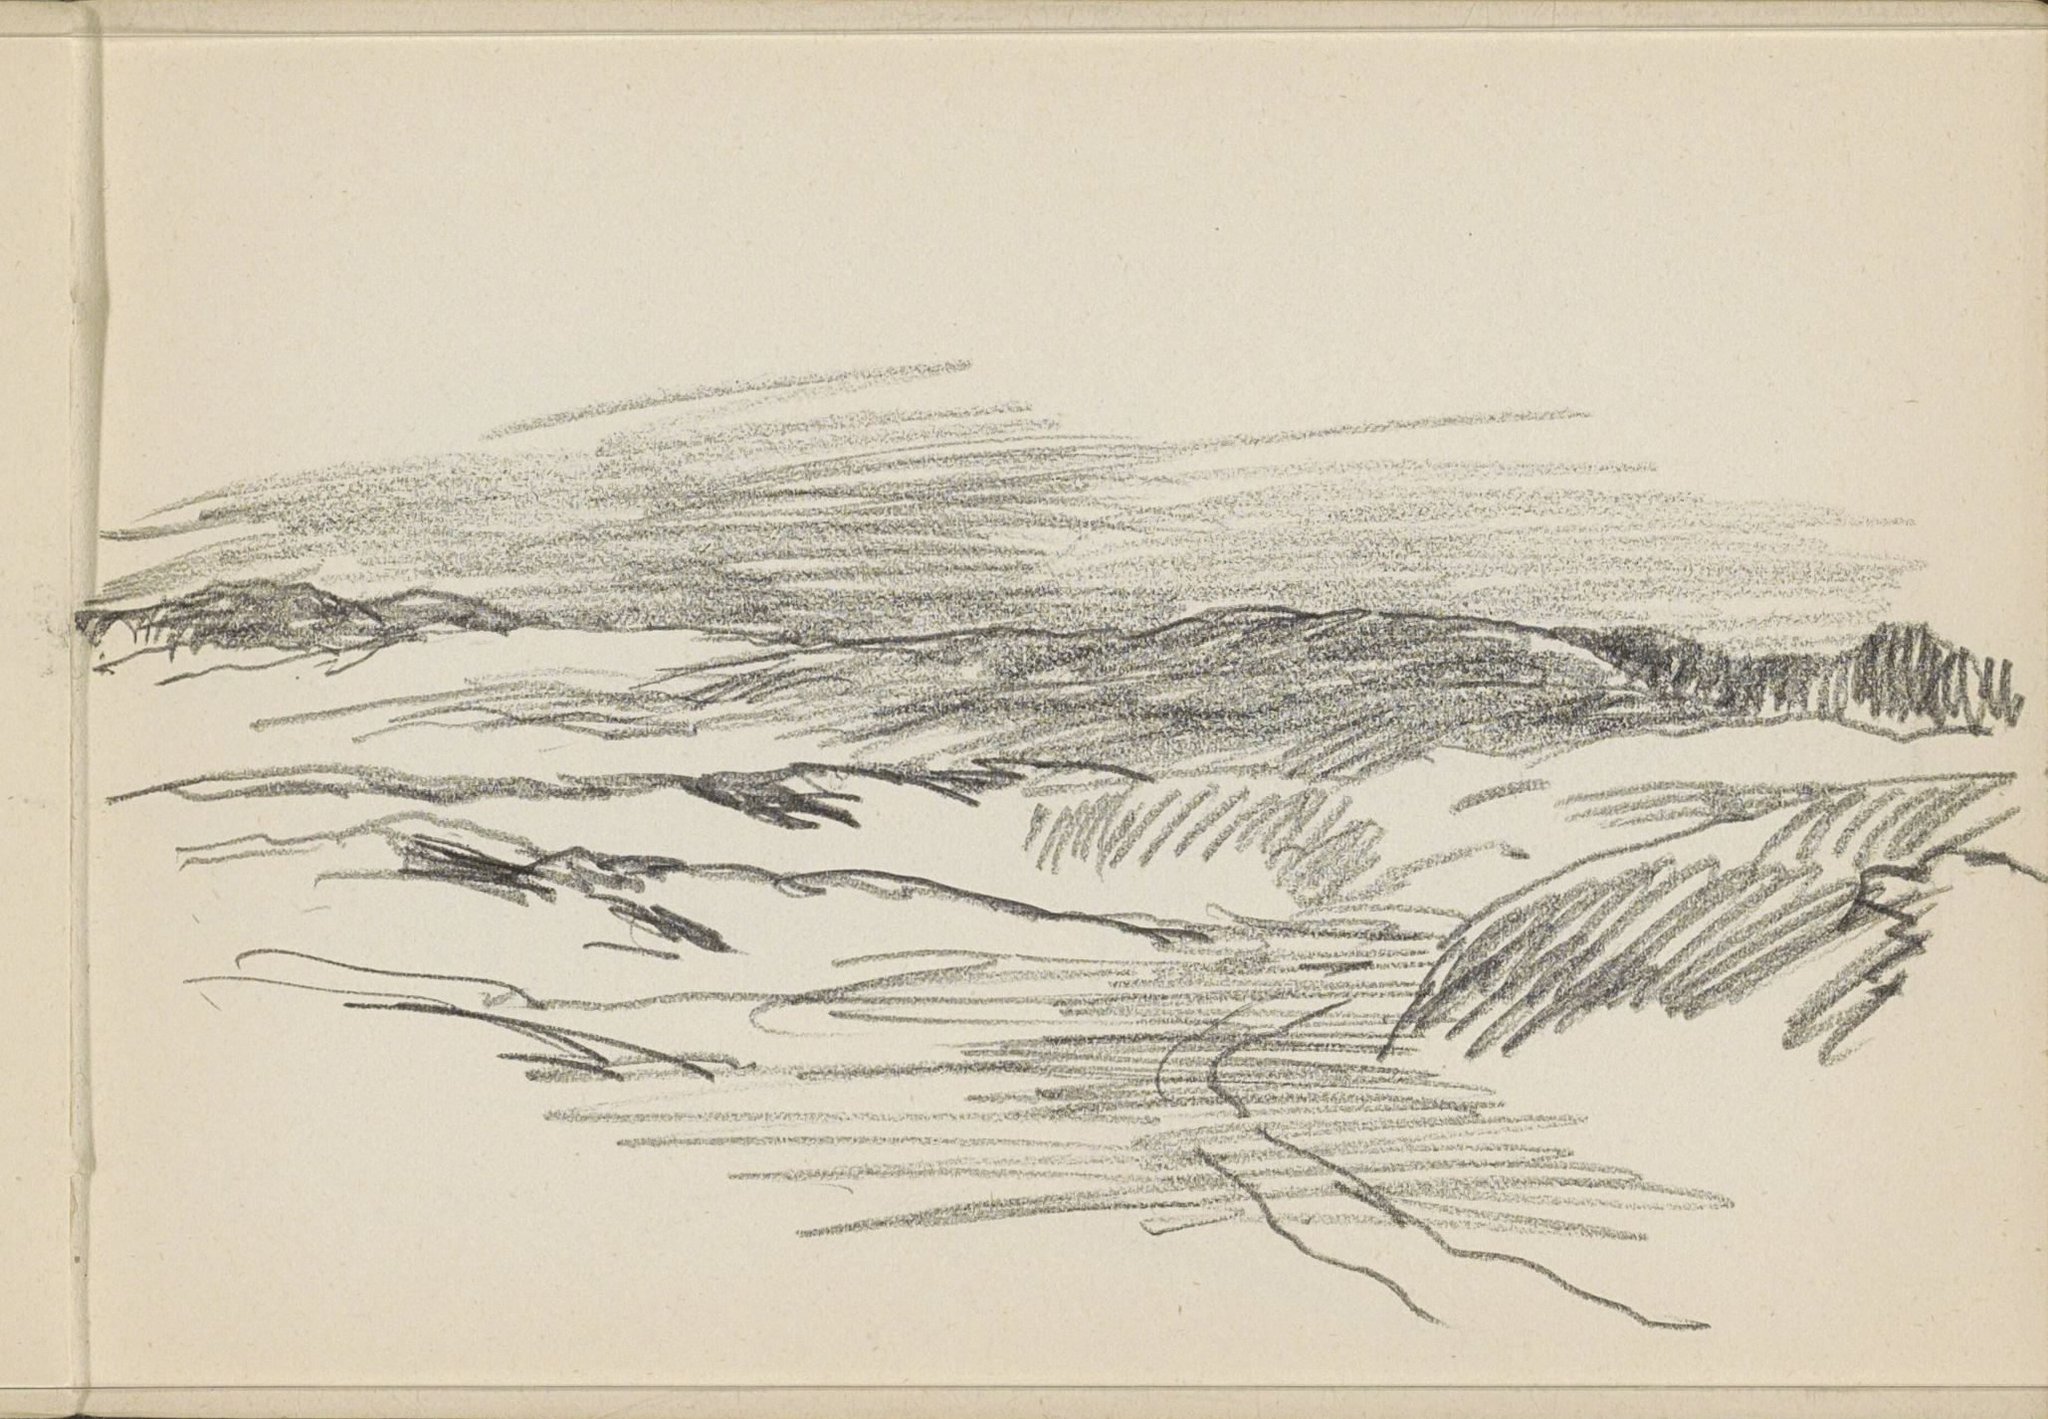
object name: sketchbook leaf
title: Duinlandschap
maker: alexander shilling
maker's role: draughtsman, print maker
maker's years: 1859-1937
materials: chalk, paper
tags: dunes (sea not visible); in the dunes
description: Blad 28 recto uit een schetsboek met 30 bladen.